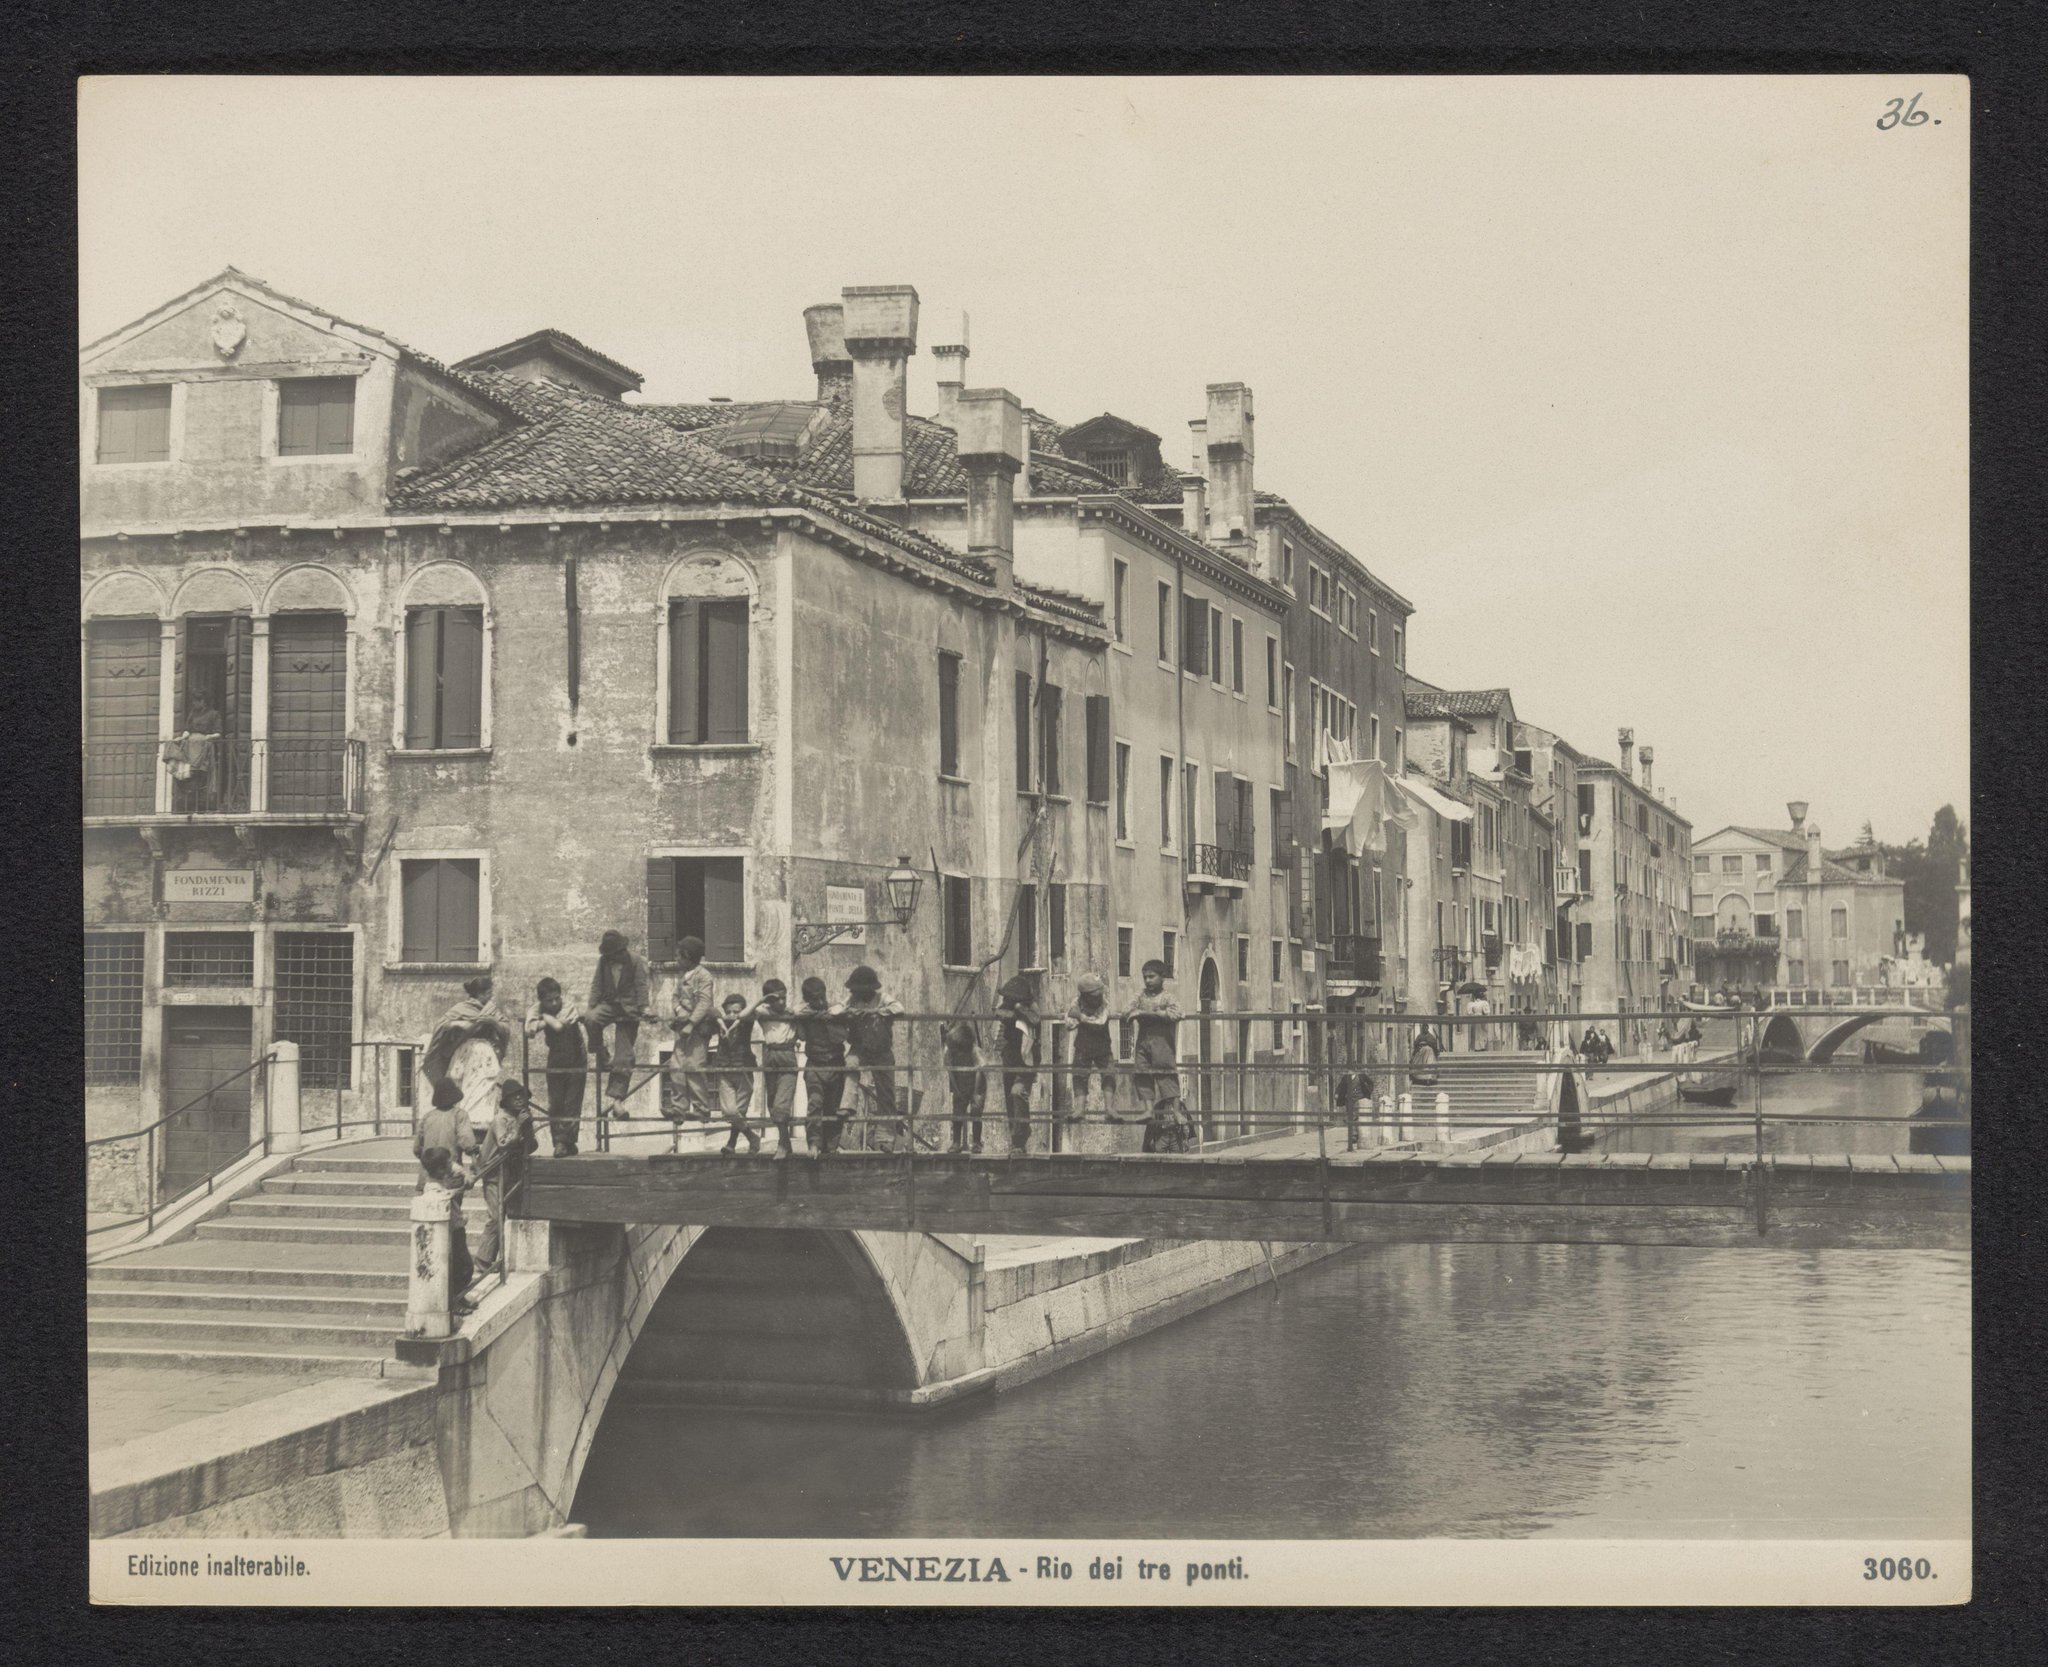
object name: photograph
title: Venezia - Rio dei tre ponti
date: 1900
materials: cardboard, photographic support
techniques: gelatin silver print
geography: venice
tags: canal, bridge, gondola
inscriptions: number: ‘3060.’, number: ‘36.’